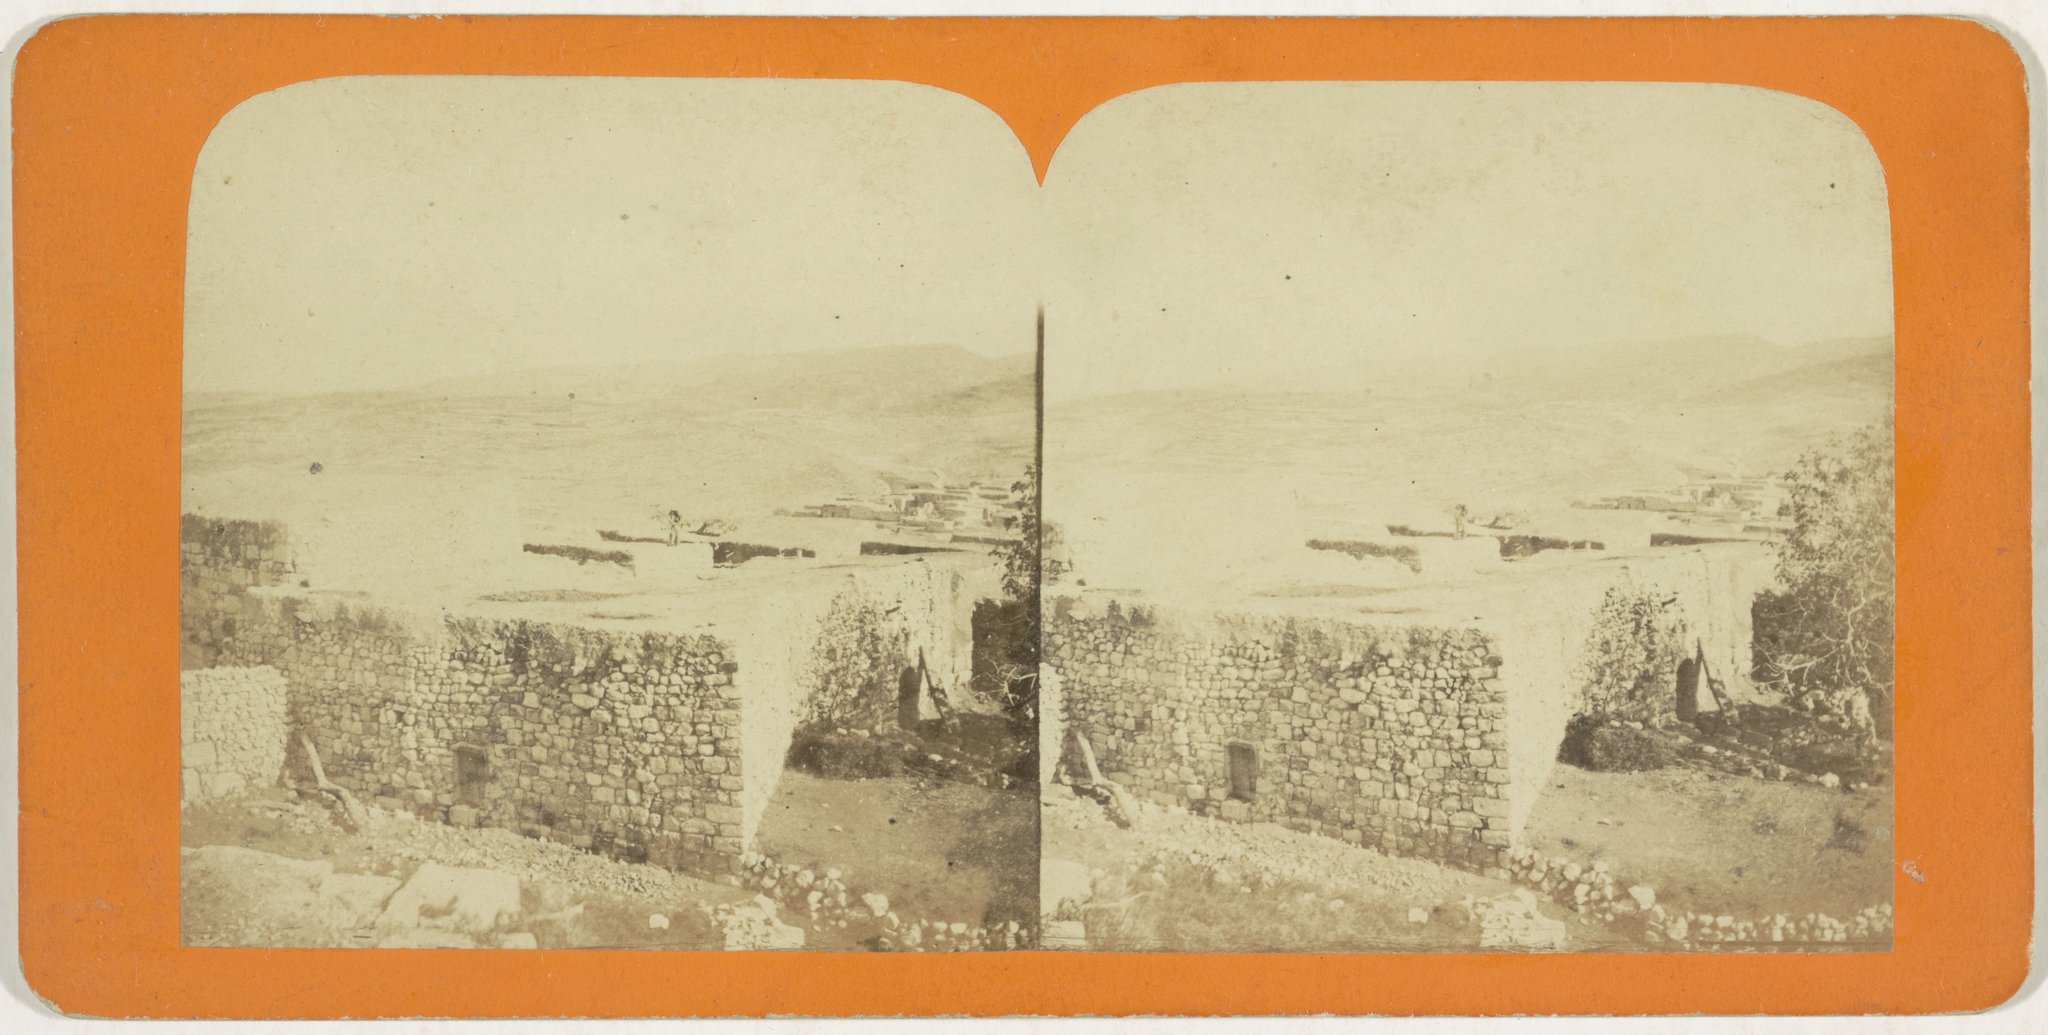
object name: stereograph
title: Cana de Galilée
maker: Anonymous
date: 1868-1890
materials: cardboard, paper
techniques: albumen print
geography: cana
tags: landscape with ruins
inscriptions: monogram: ‘DB/ R’